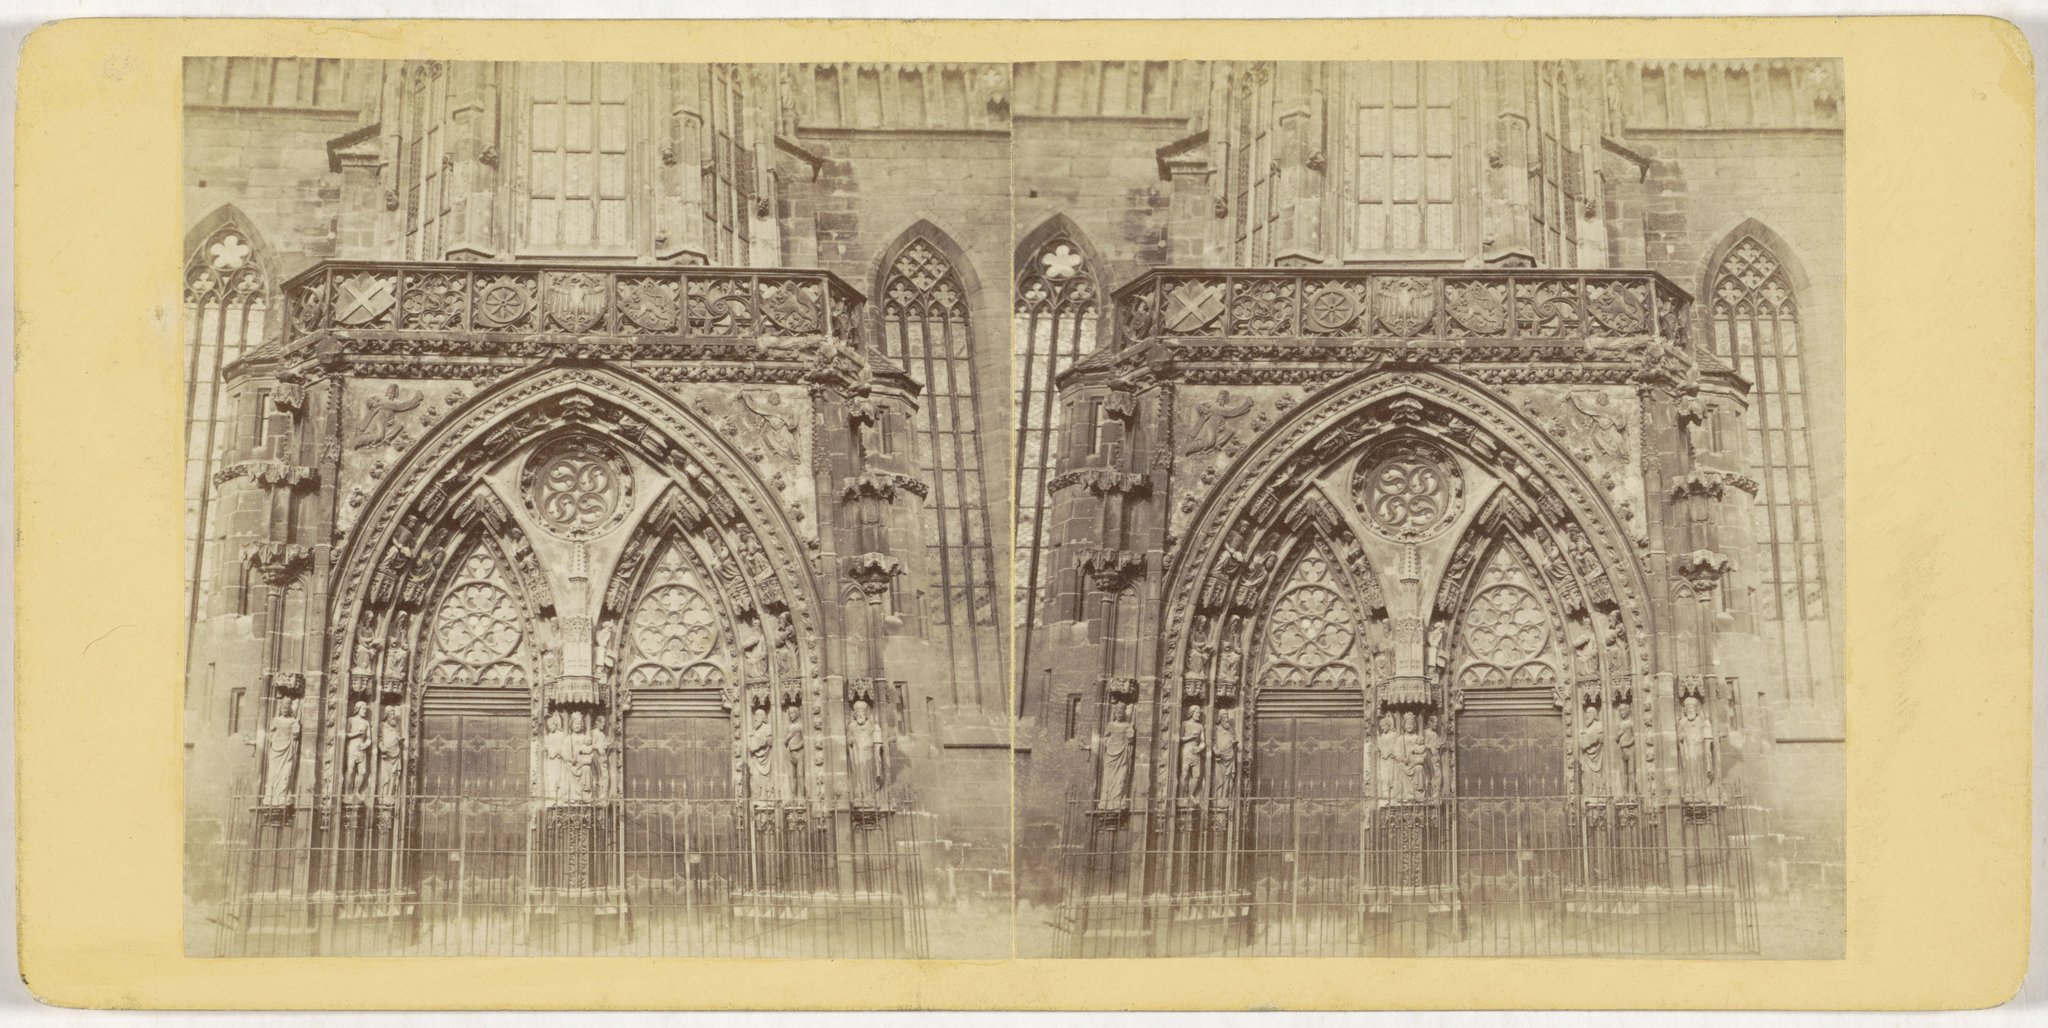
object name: stereograph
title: Portaal van de Onze-Lieve-Vrouwekerk in Neurenberg, Duitsland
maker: johann friedrich stiehm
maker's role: fotograaf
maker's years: 1826-1902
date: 1863-1868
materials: cardboard, paper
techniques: albumen print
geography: london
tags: parts of church exterior and annexes: portal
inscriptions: number: ‘No. 6.’